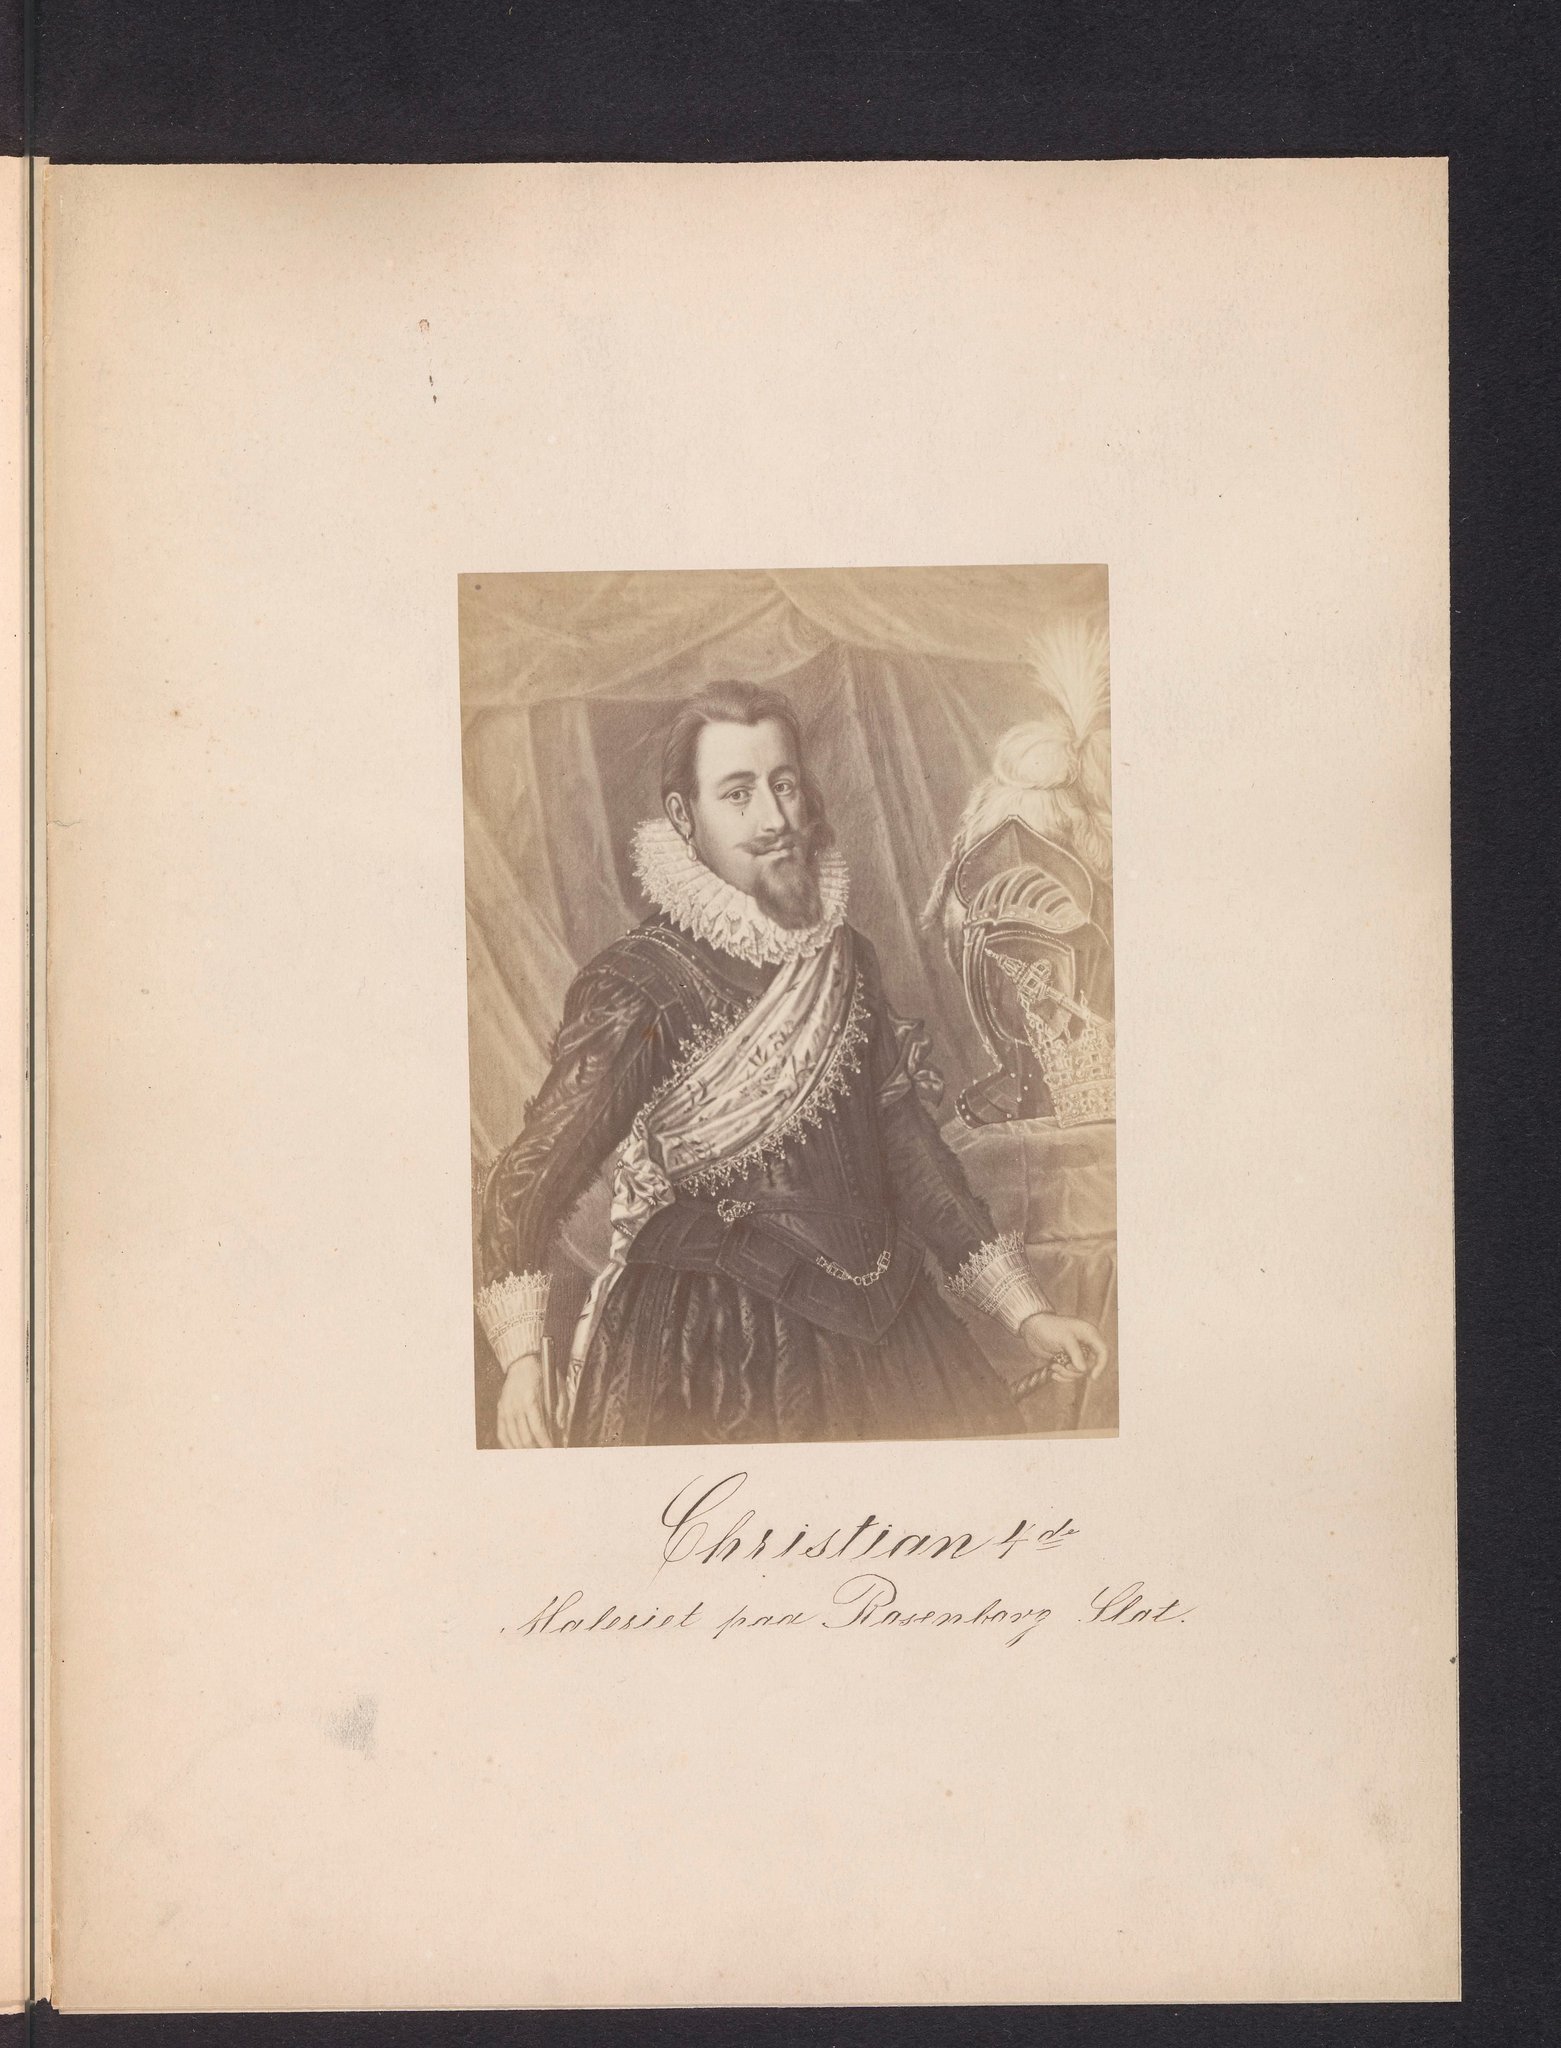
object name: reproduction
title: Fotoreproductie van een schilderij, voorstellende een portret van koning Christiaan IV van Denemarken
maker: julius wulff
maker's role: fotograaf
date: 1858-1862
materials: photographic support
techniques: albumen print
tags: copenhagen (city), christiaan iv (koning van denemarken en noorwegen), ruler, sovereign, insignia and symbols of sovereignty (crown, diadem, sceptre, orb, seal, standard, cloak, pectoral)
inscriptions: inscription: ‘Maleriet paa Rosenborg Slot.’